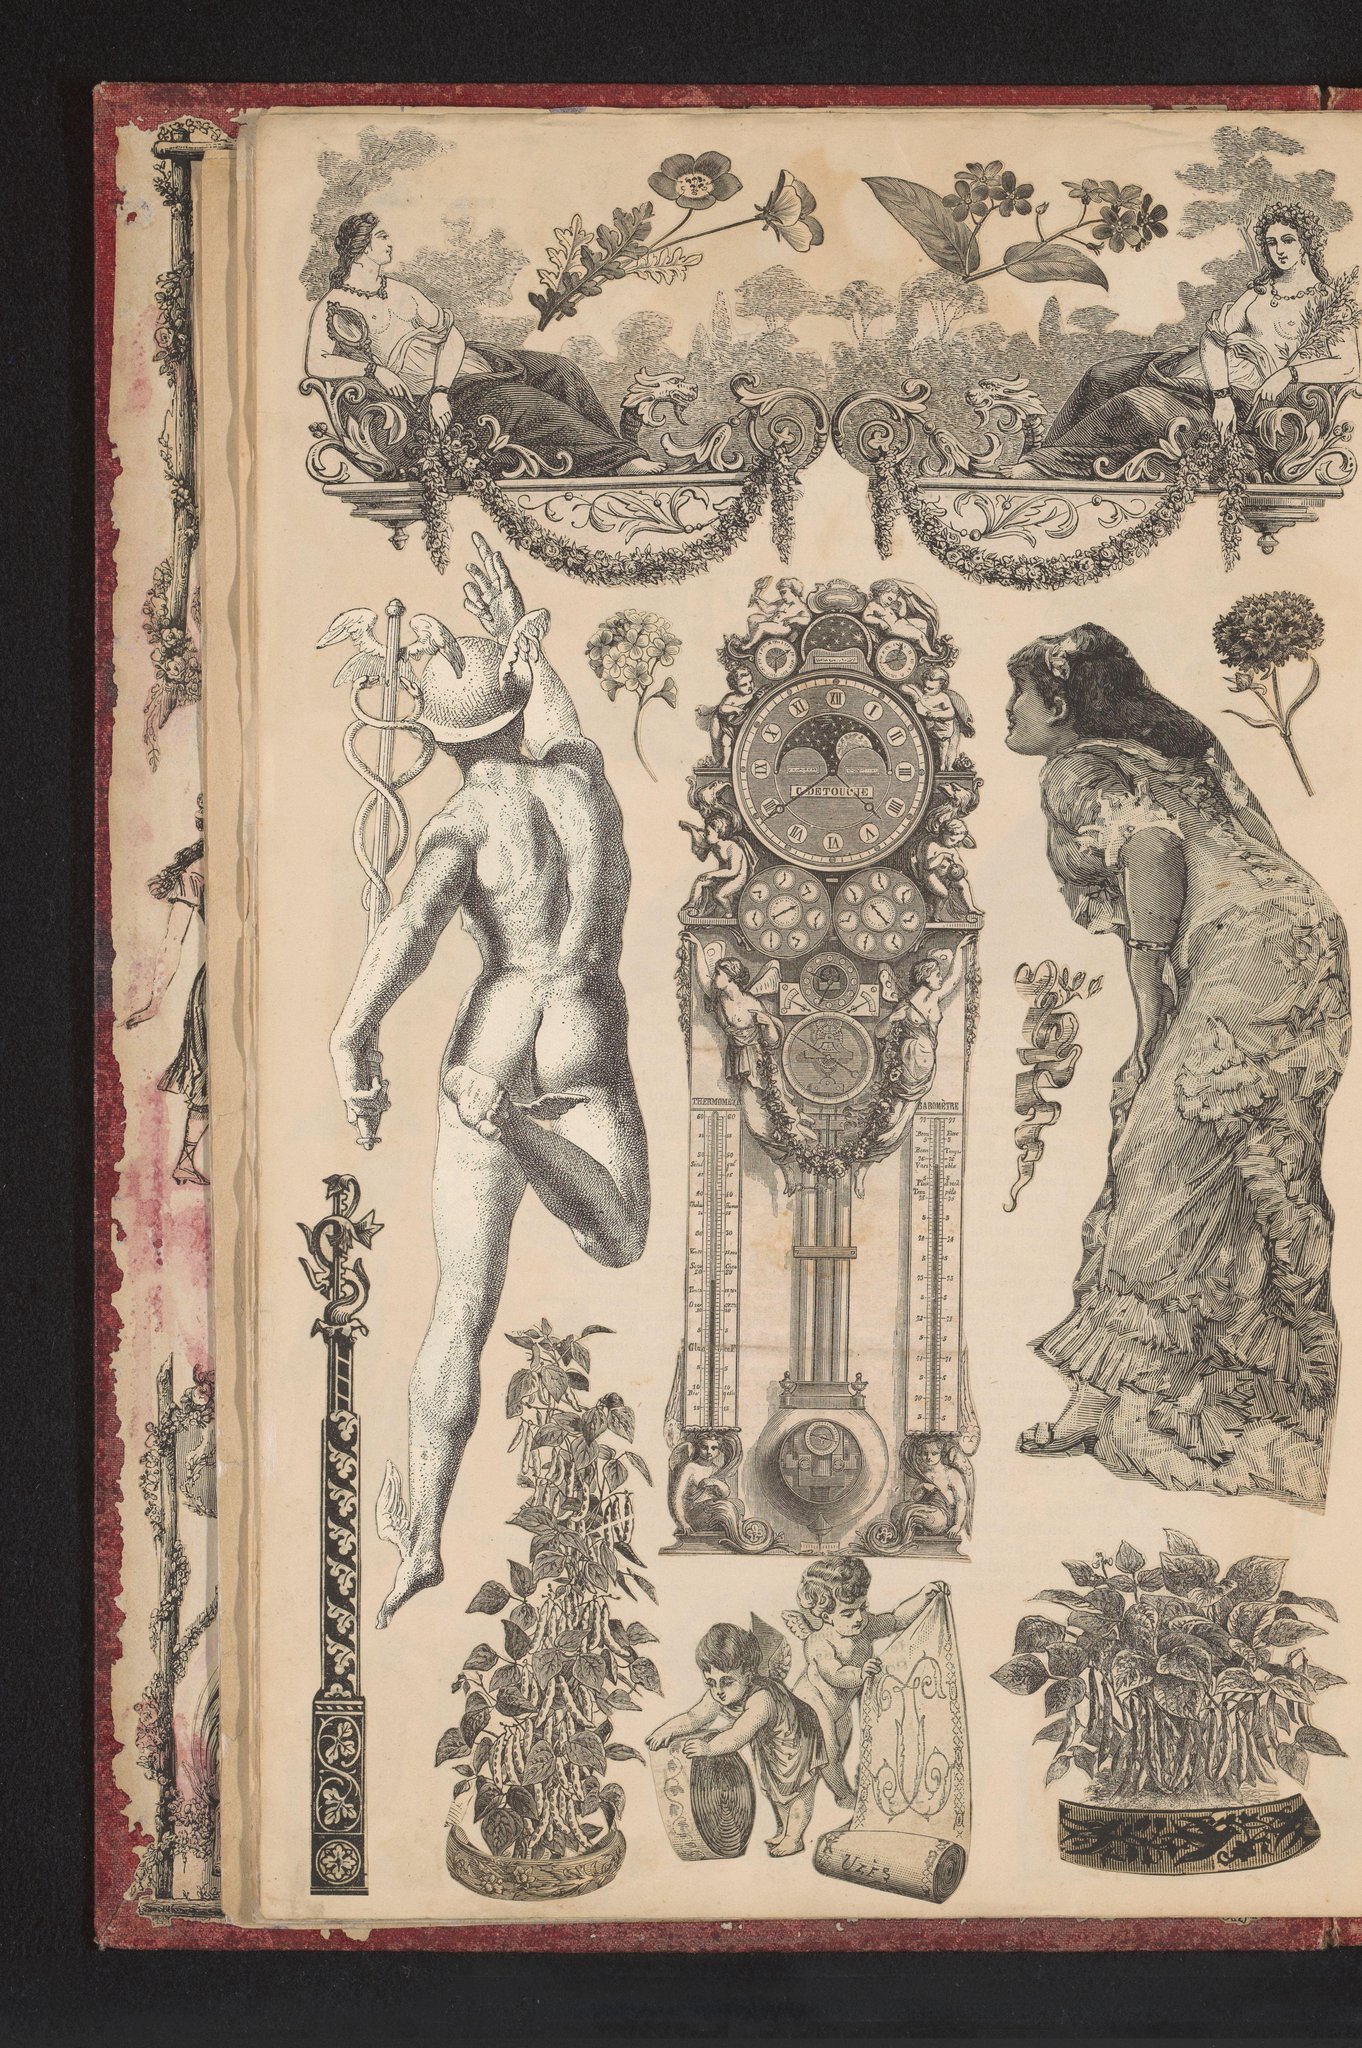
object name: collage visual work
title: Collage van uitgeknipte prenten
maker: Anonymous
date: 1870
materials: paper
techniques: engraving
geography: paris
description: Collage van uitgeknipte prenten. Onderdeel van een album met 32 bladen, aan beide zijden beplakt met uitgeknipte prenten, vermoedelijk afkomstig uit 19e-eeuwse tijdschiften.